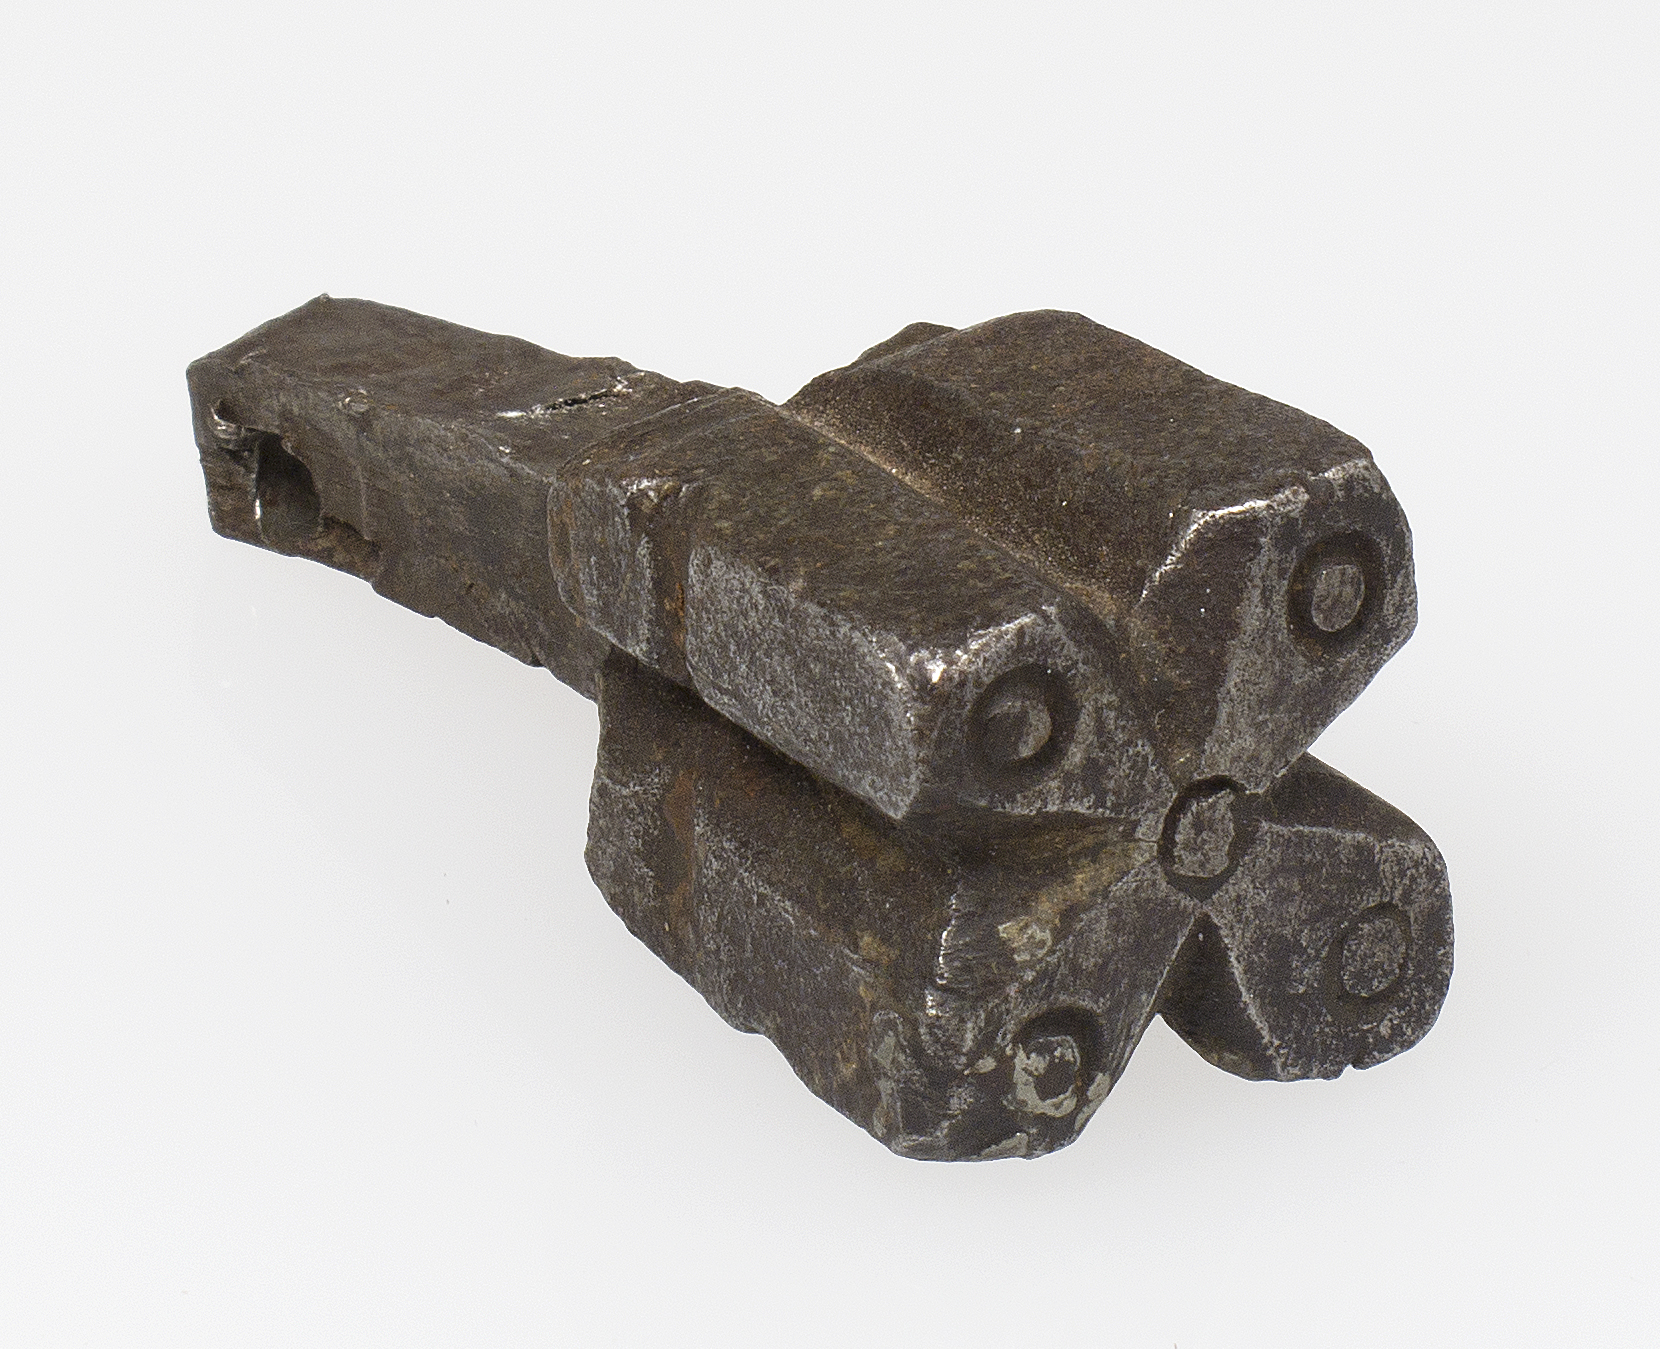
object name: nail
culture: european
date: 1401-1600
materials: iron